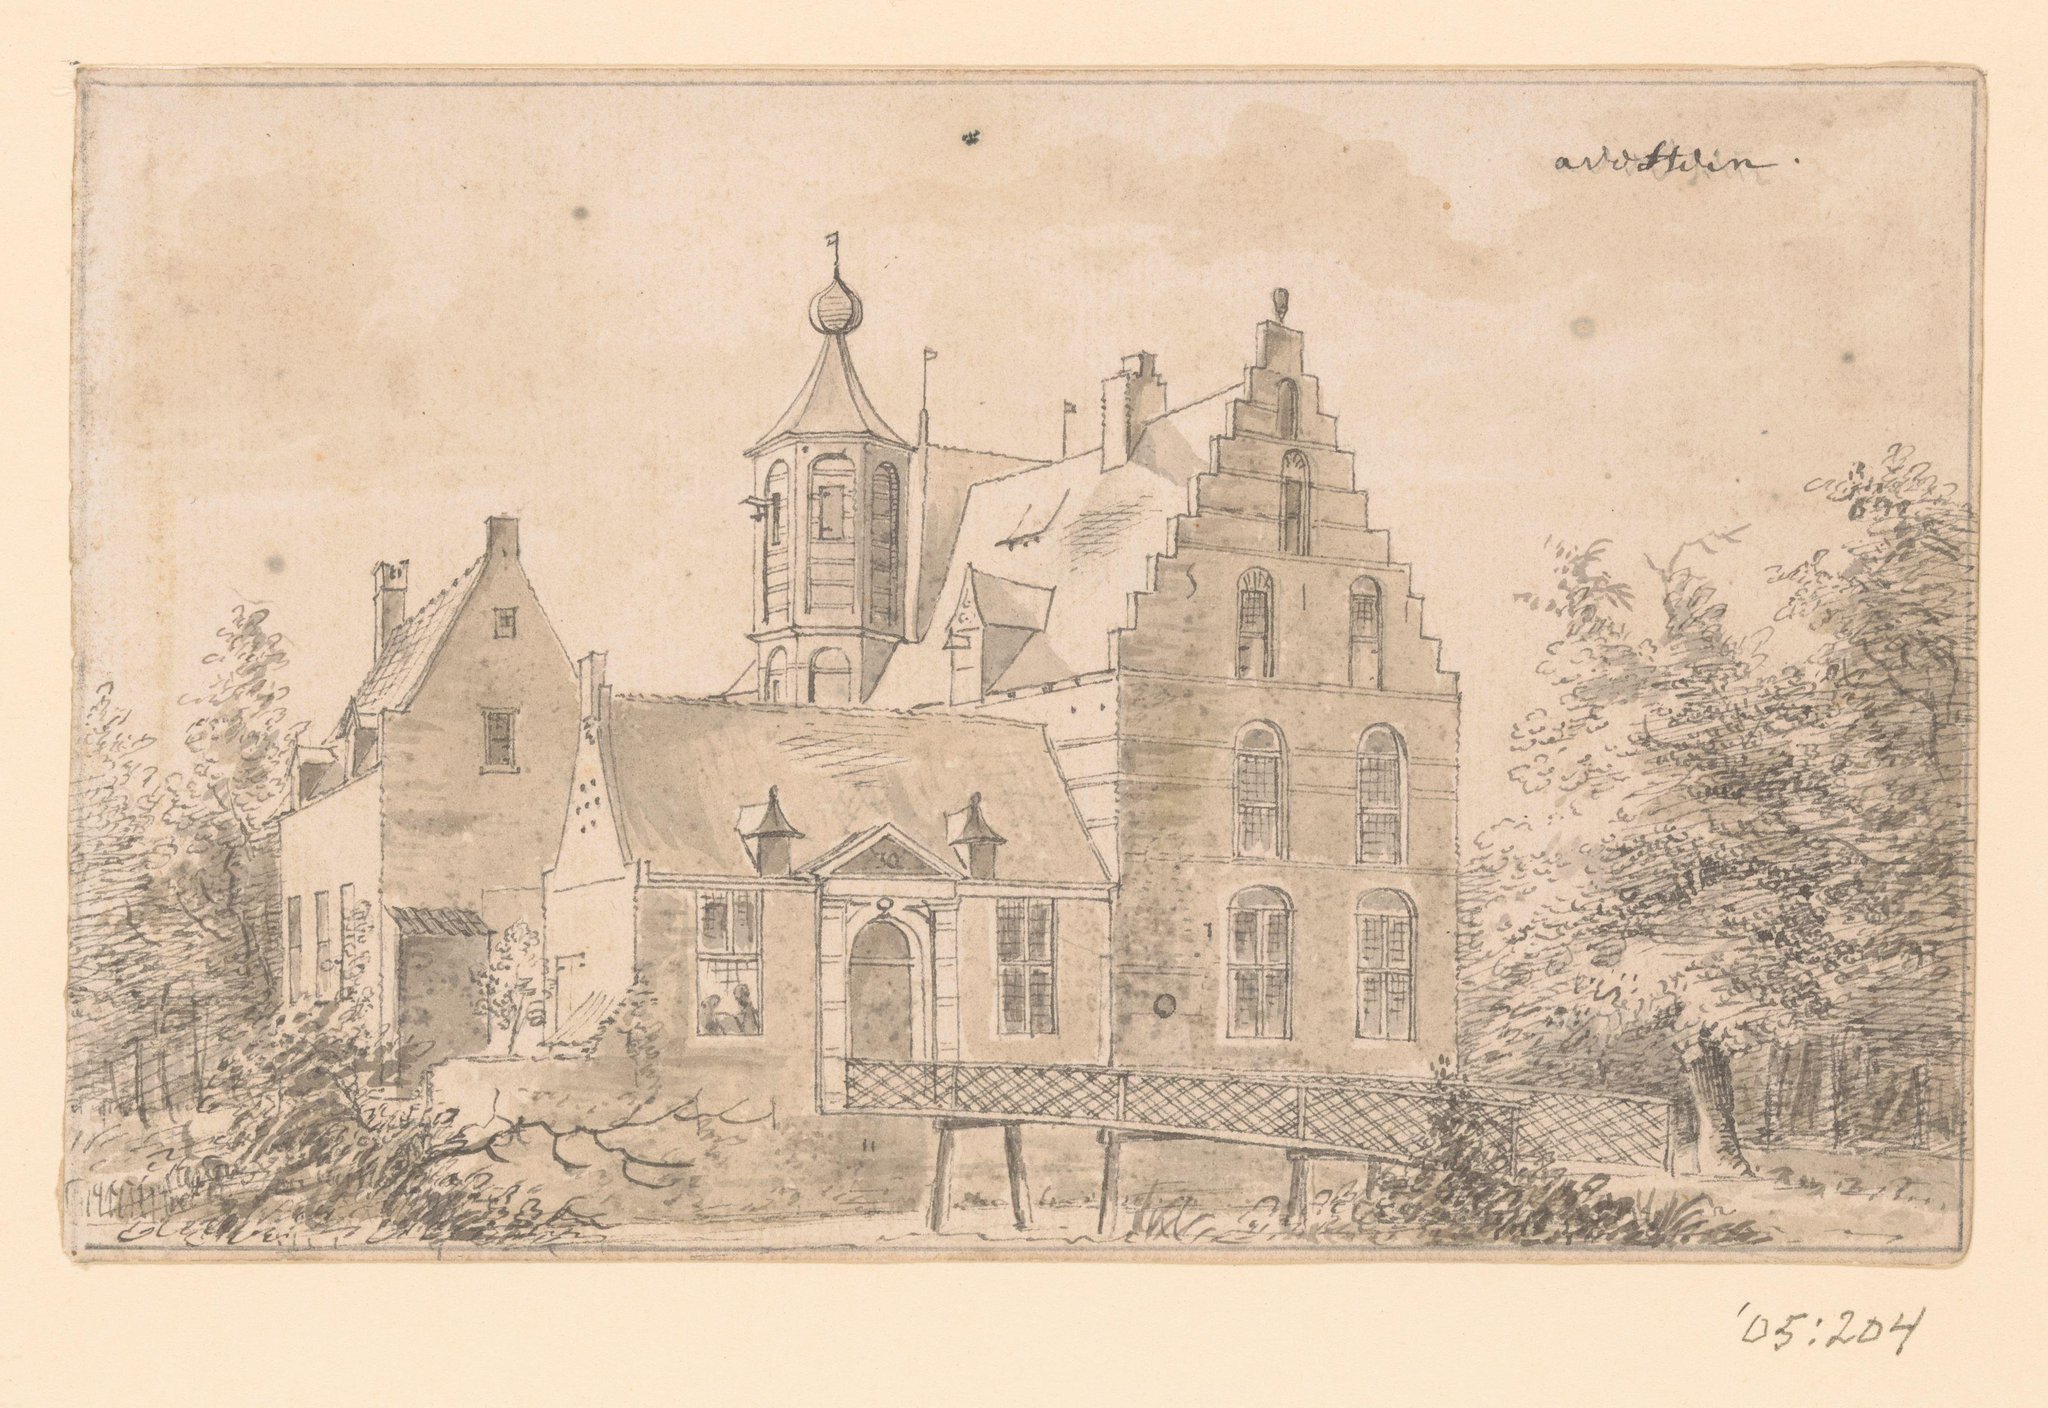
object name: drawing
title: Gezicht op Kasteel Avestein bij Dinther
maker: Anonymous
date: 1750-1850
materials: ink, paper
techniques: drawing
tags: castle, landscape with tower or castle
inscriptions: collector's mark: Lugt 2228